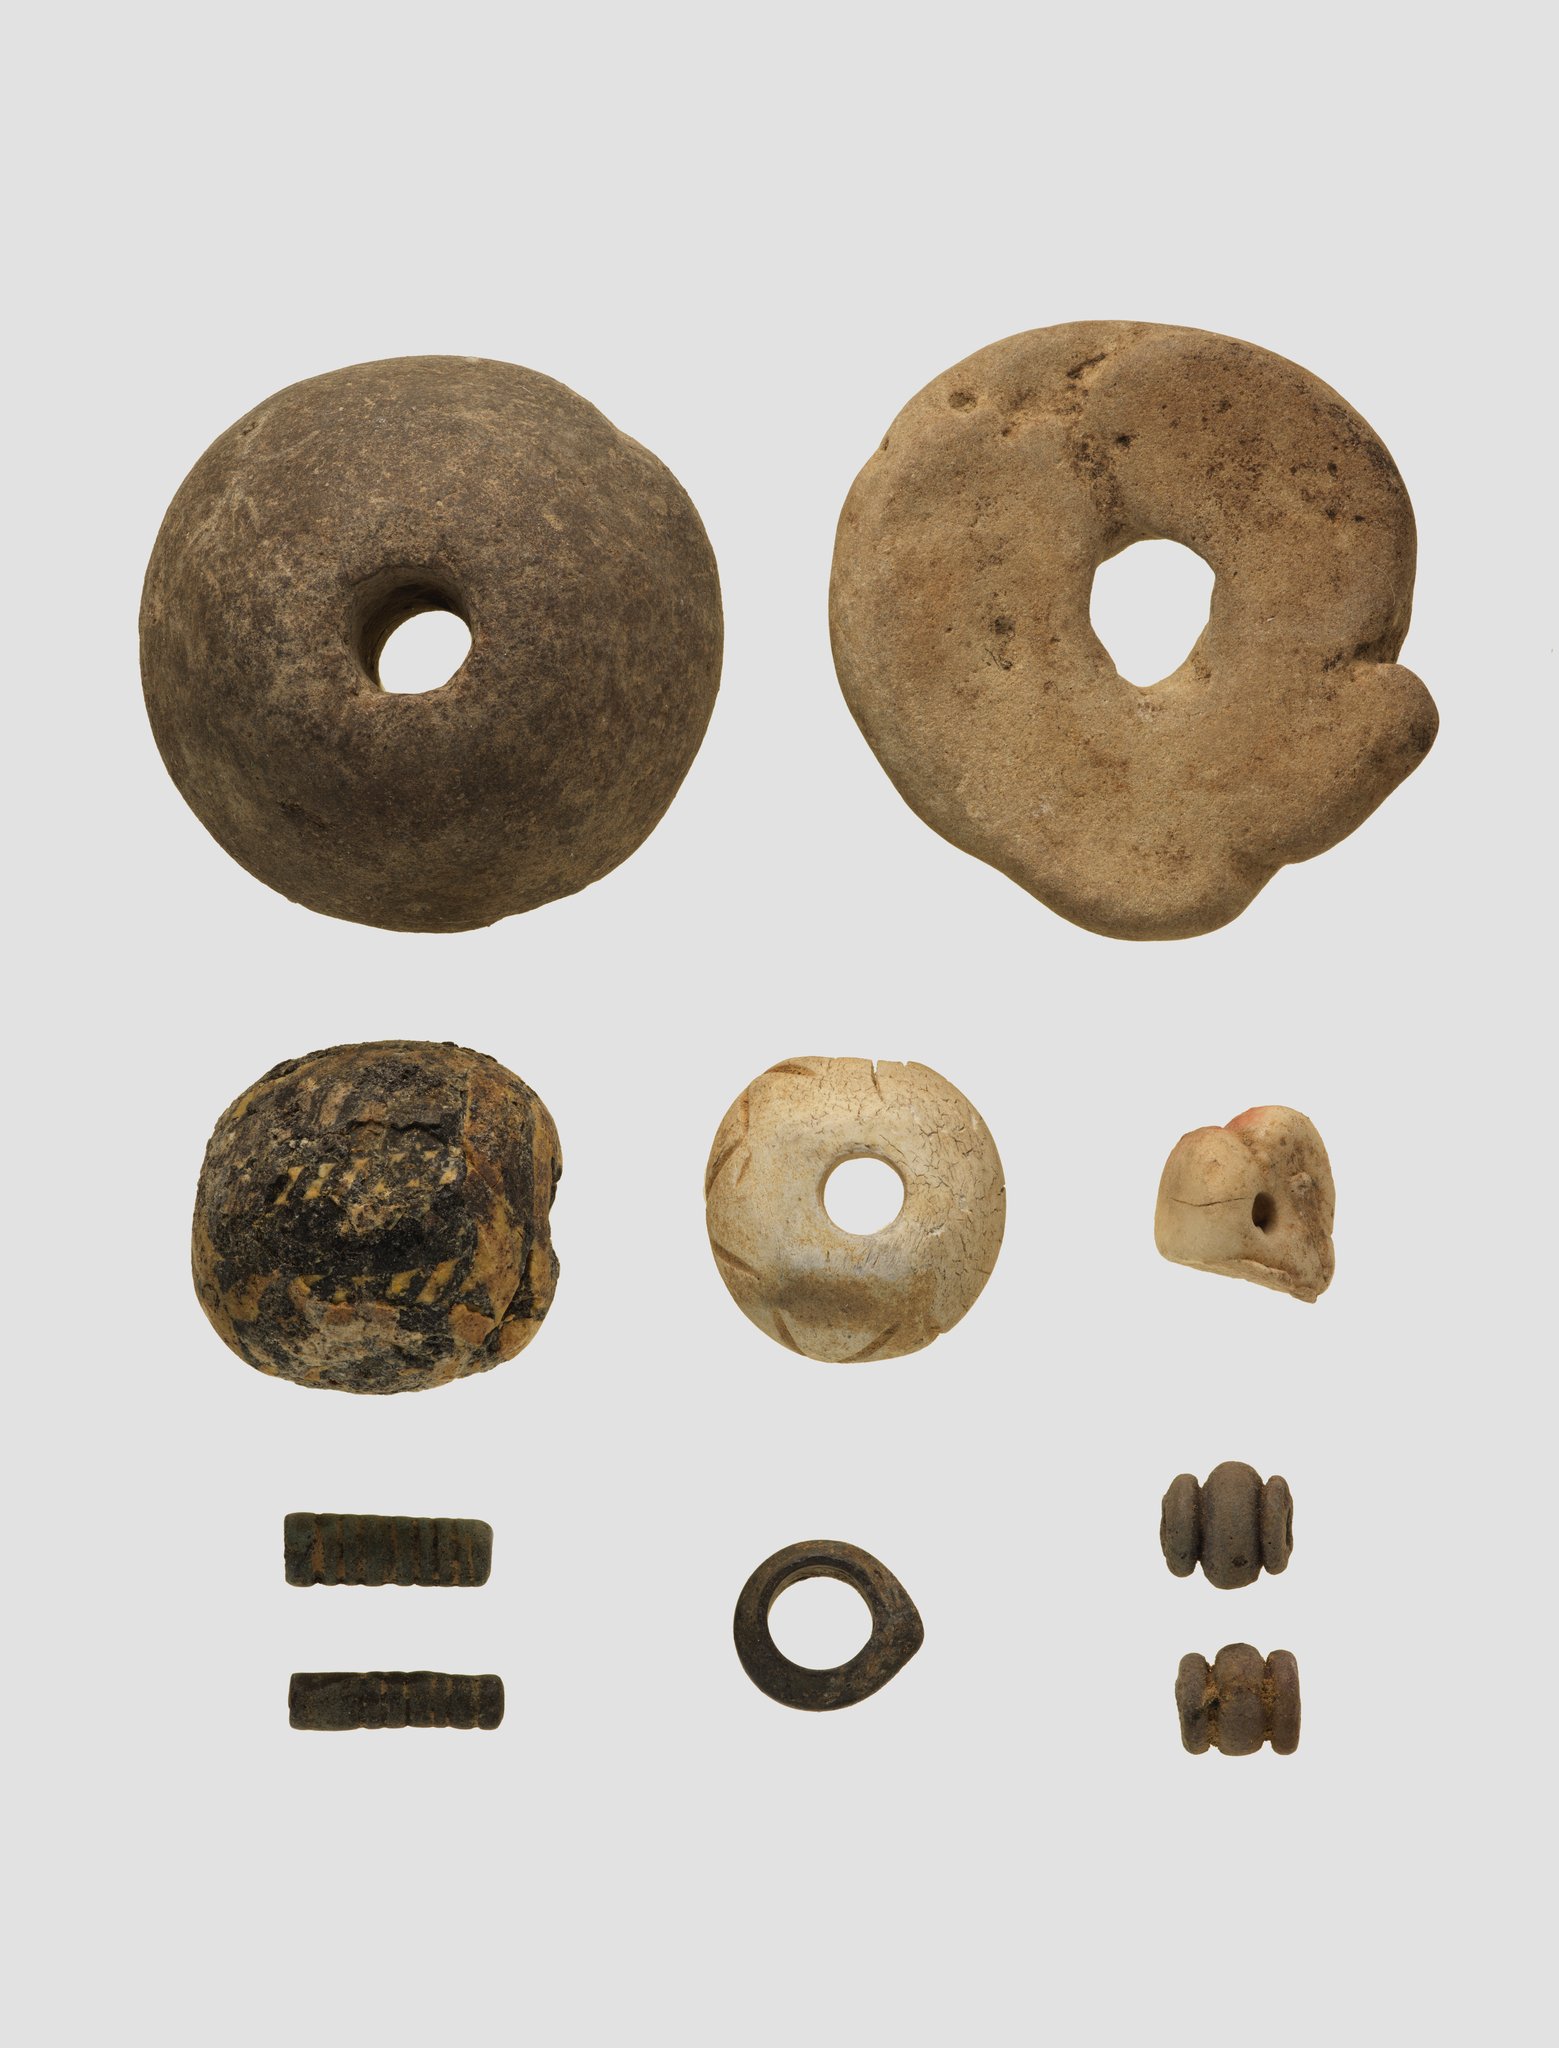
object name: bead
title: Beads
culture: iranian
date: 900-801 BCE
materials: bone, faience, stone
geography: iran